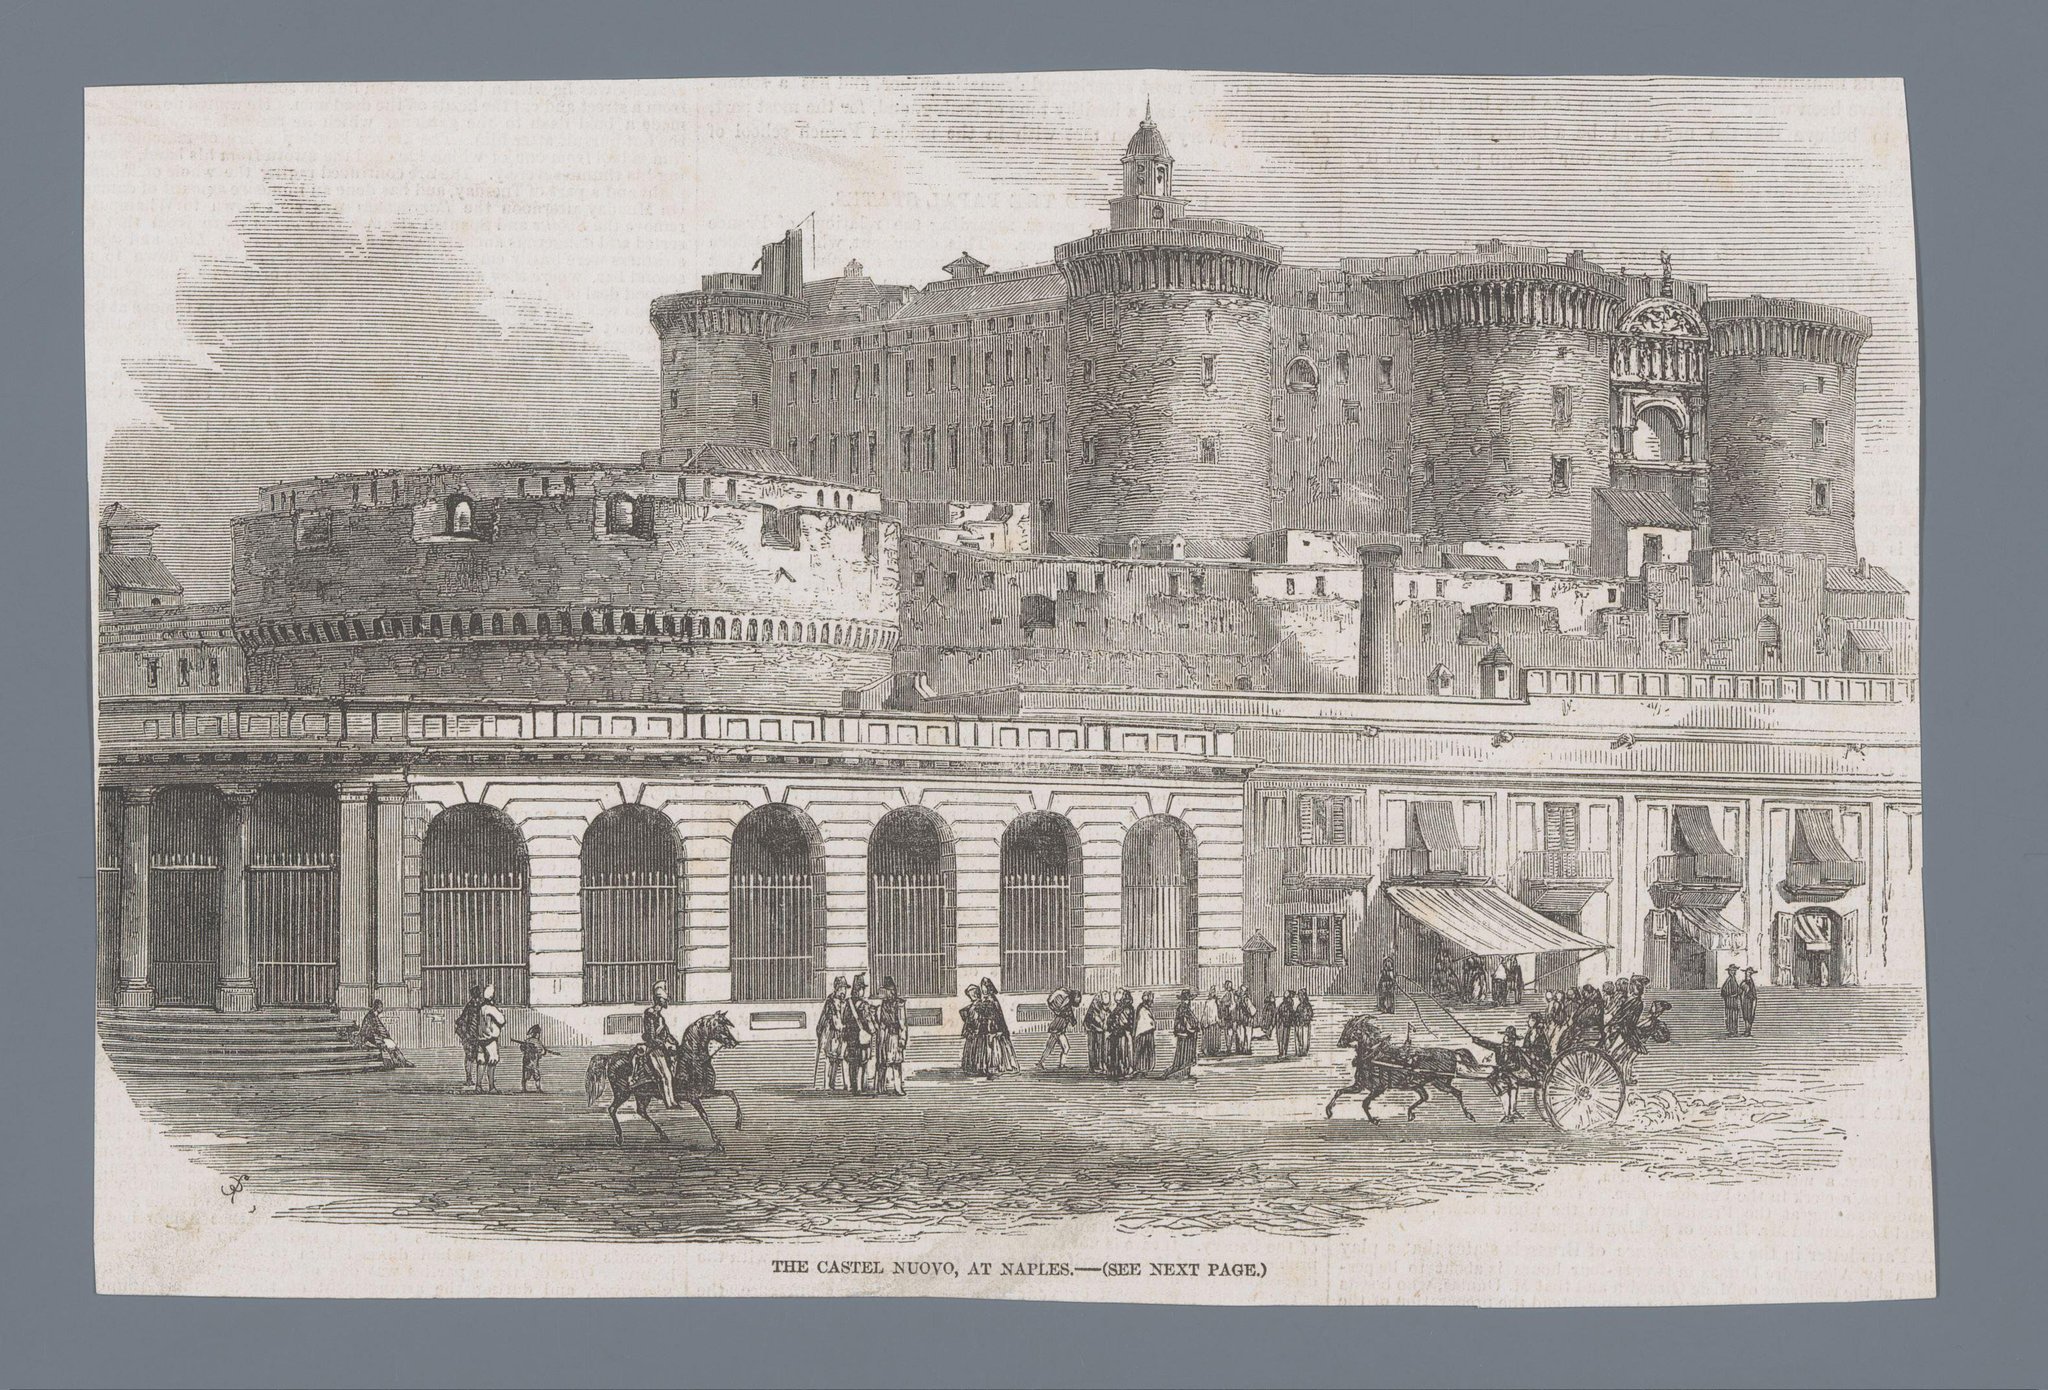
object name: print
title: The Castel Nuovo, at Naples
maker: Anonymous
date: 1857-1870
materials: paper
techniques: letterpress printing, engraving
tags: fortress, castle, naples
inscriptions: monogram: ‘RJ’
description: Prent komt waarschijnlijk uit een Engelse krant tussen 1857 en 1870.